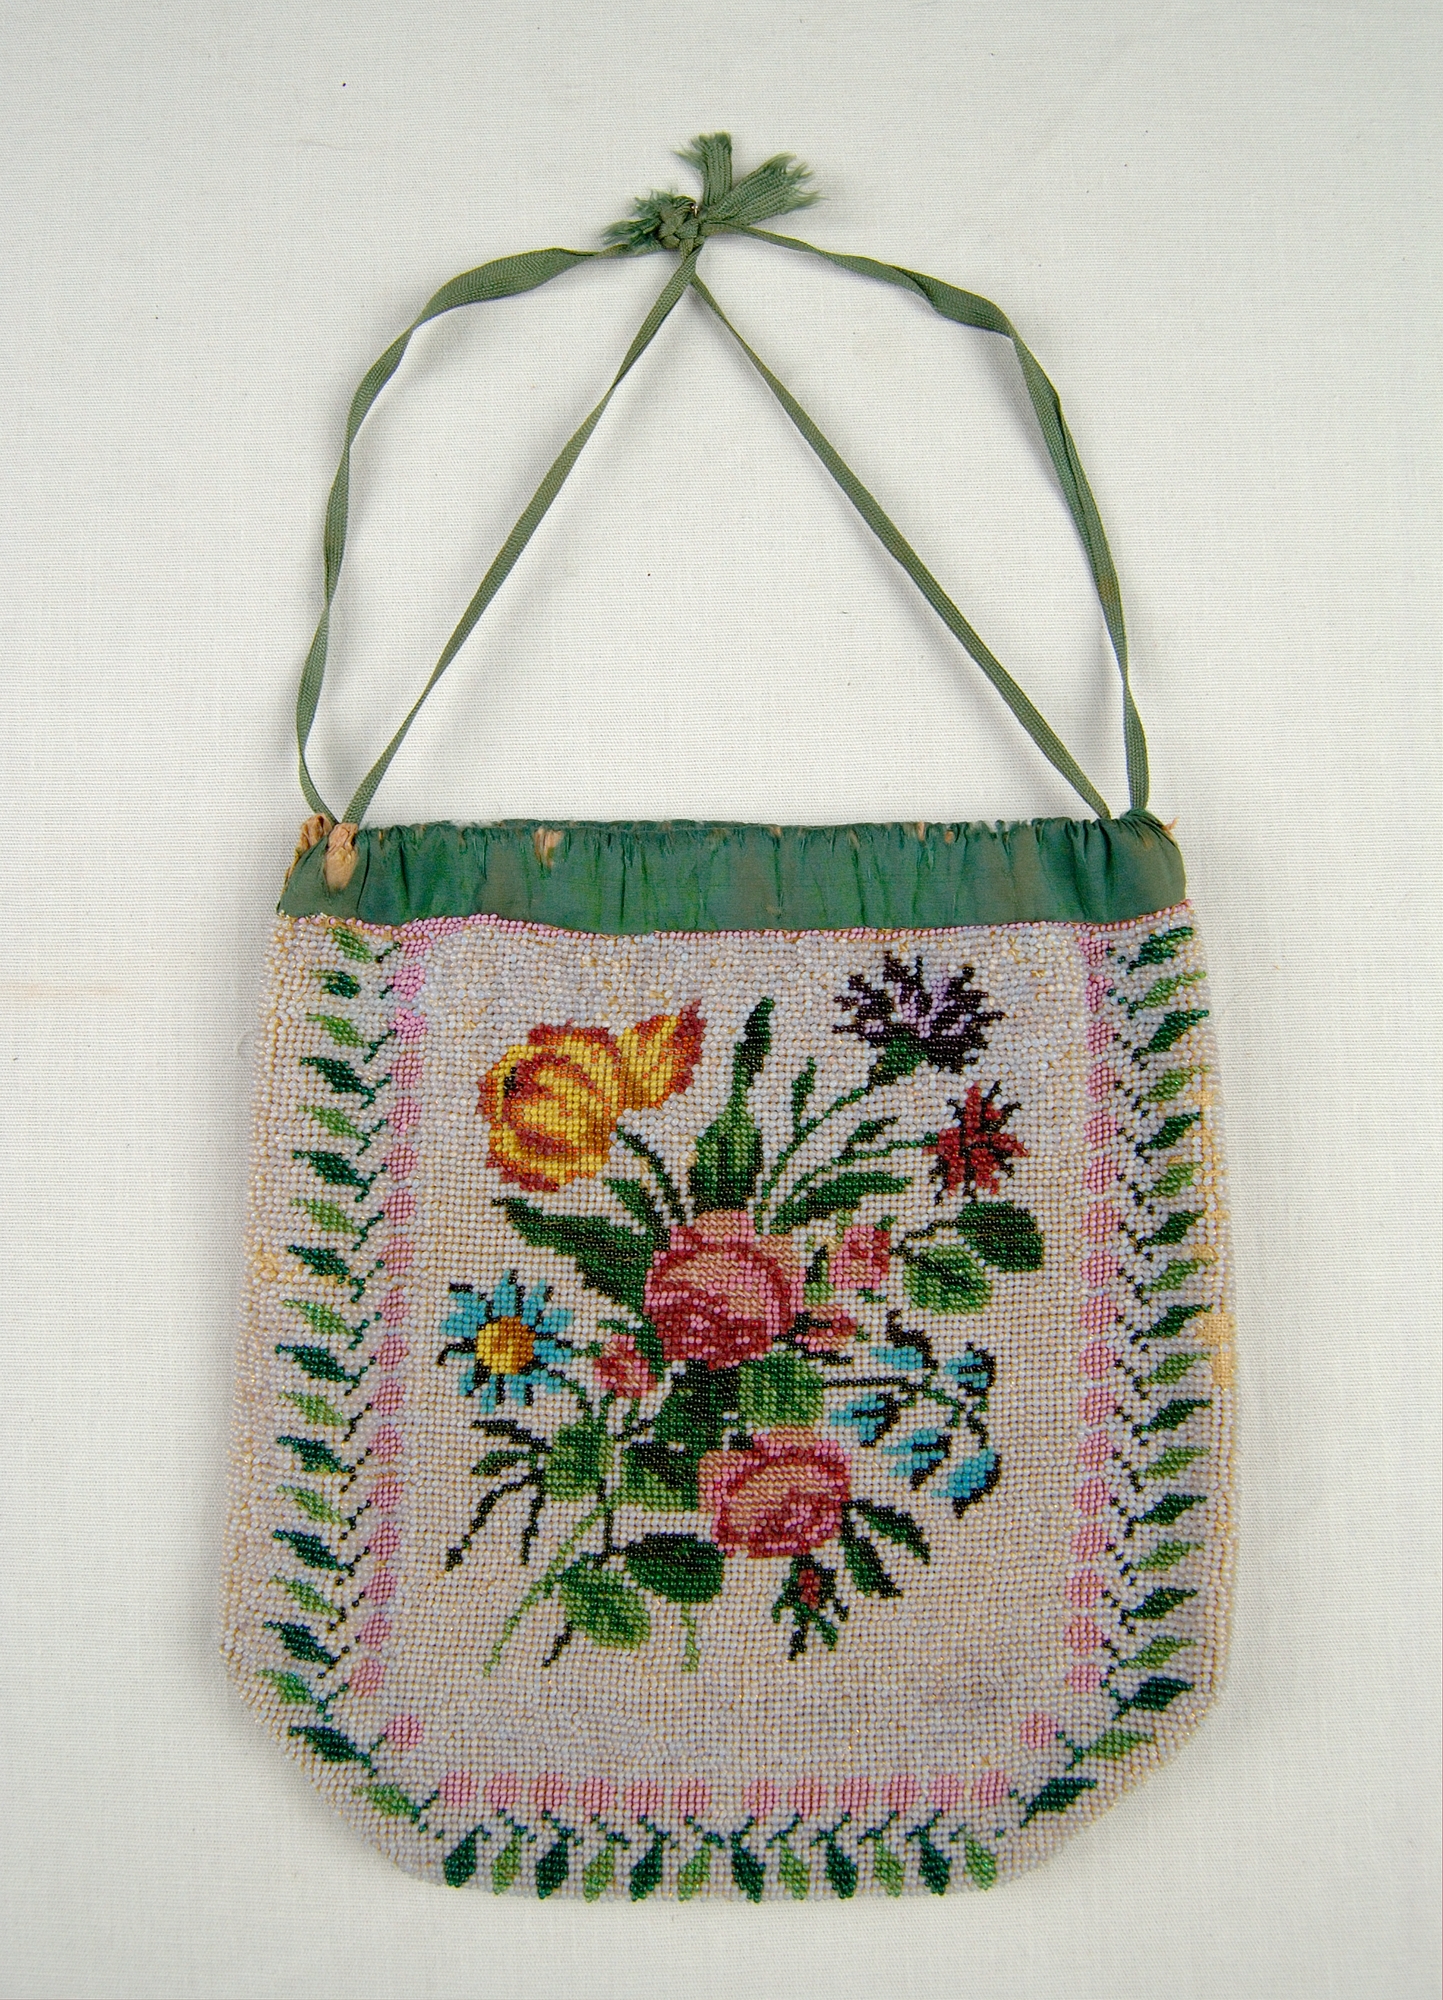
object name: pouch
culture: american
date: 1830-1860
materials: cotton, glass, linen, silk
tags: flowers